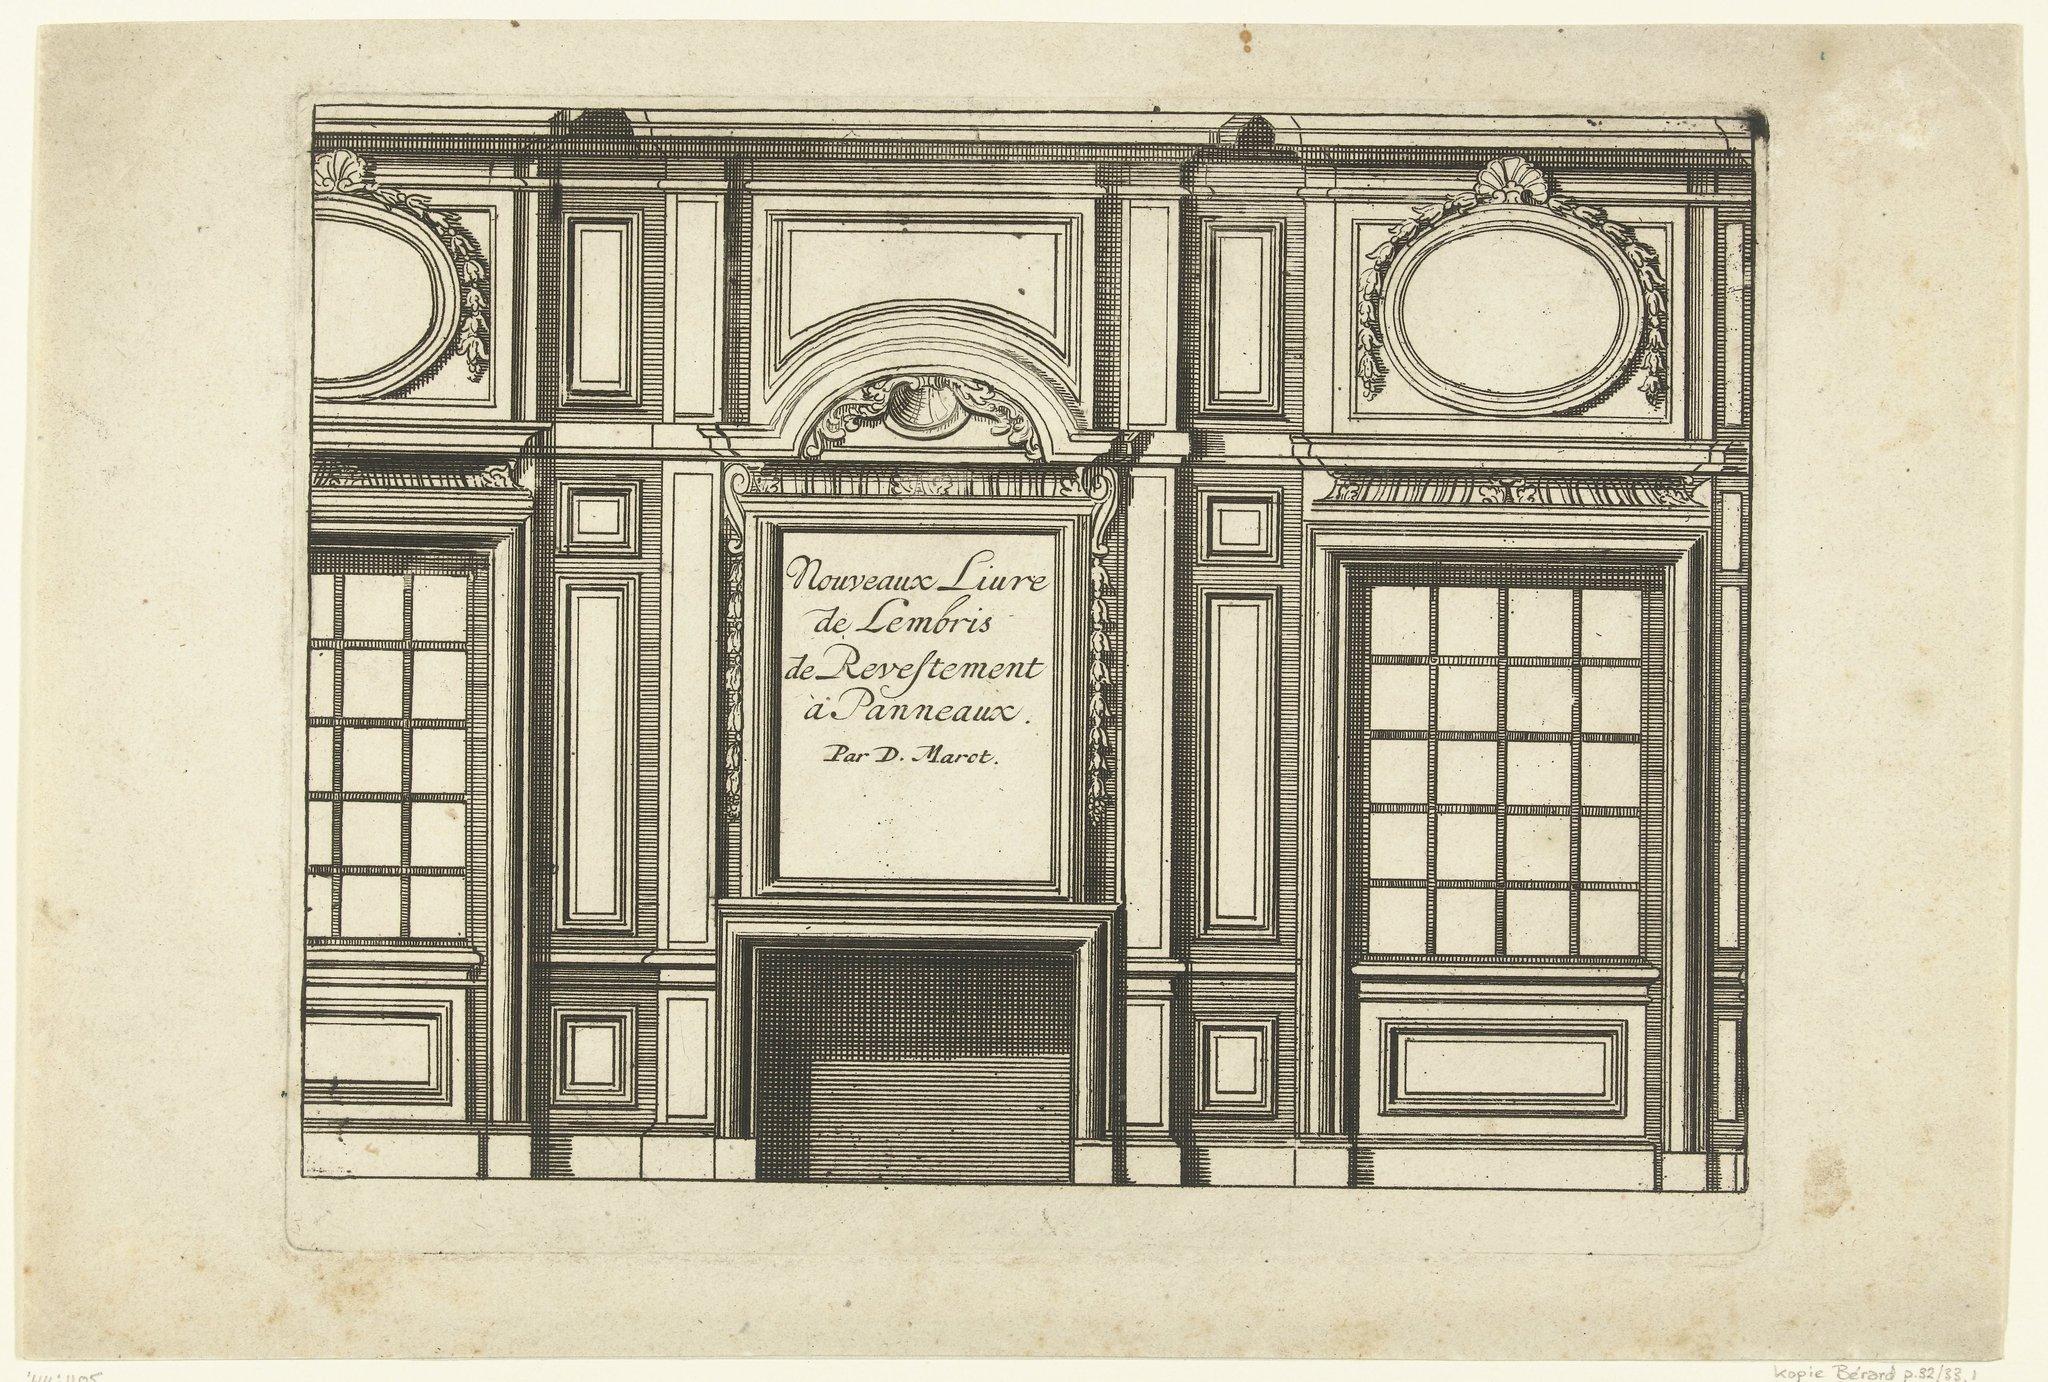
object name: print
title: Nouveaux Liure de Lembris de Revestement à Panneaux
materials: paper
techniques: etching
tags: chimney-piece, mantelpiece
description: Muur met een schoorsteen tussen twee ramen. Op de spiegel staat de titel. Tegenzijdige kopie naar blad uit serie Nouveaux Liure de Lembris et Revestement à Panneaux uitgegeven door Daniel Marot.